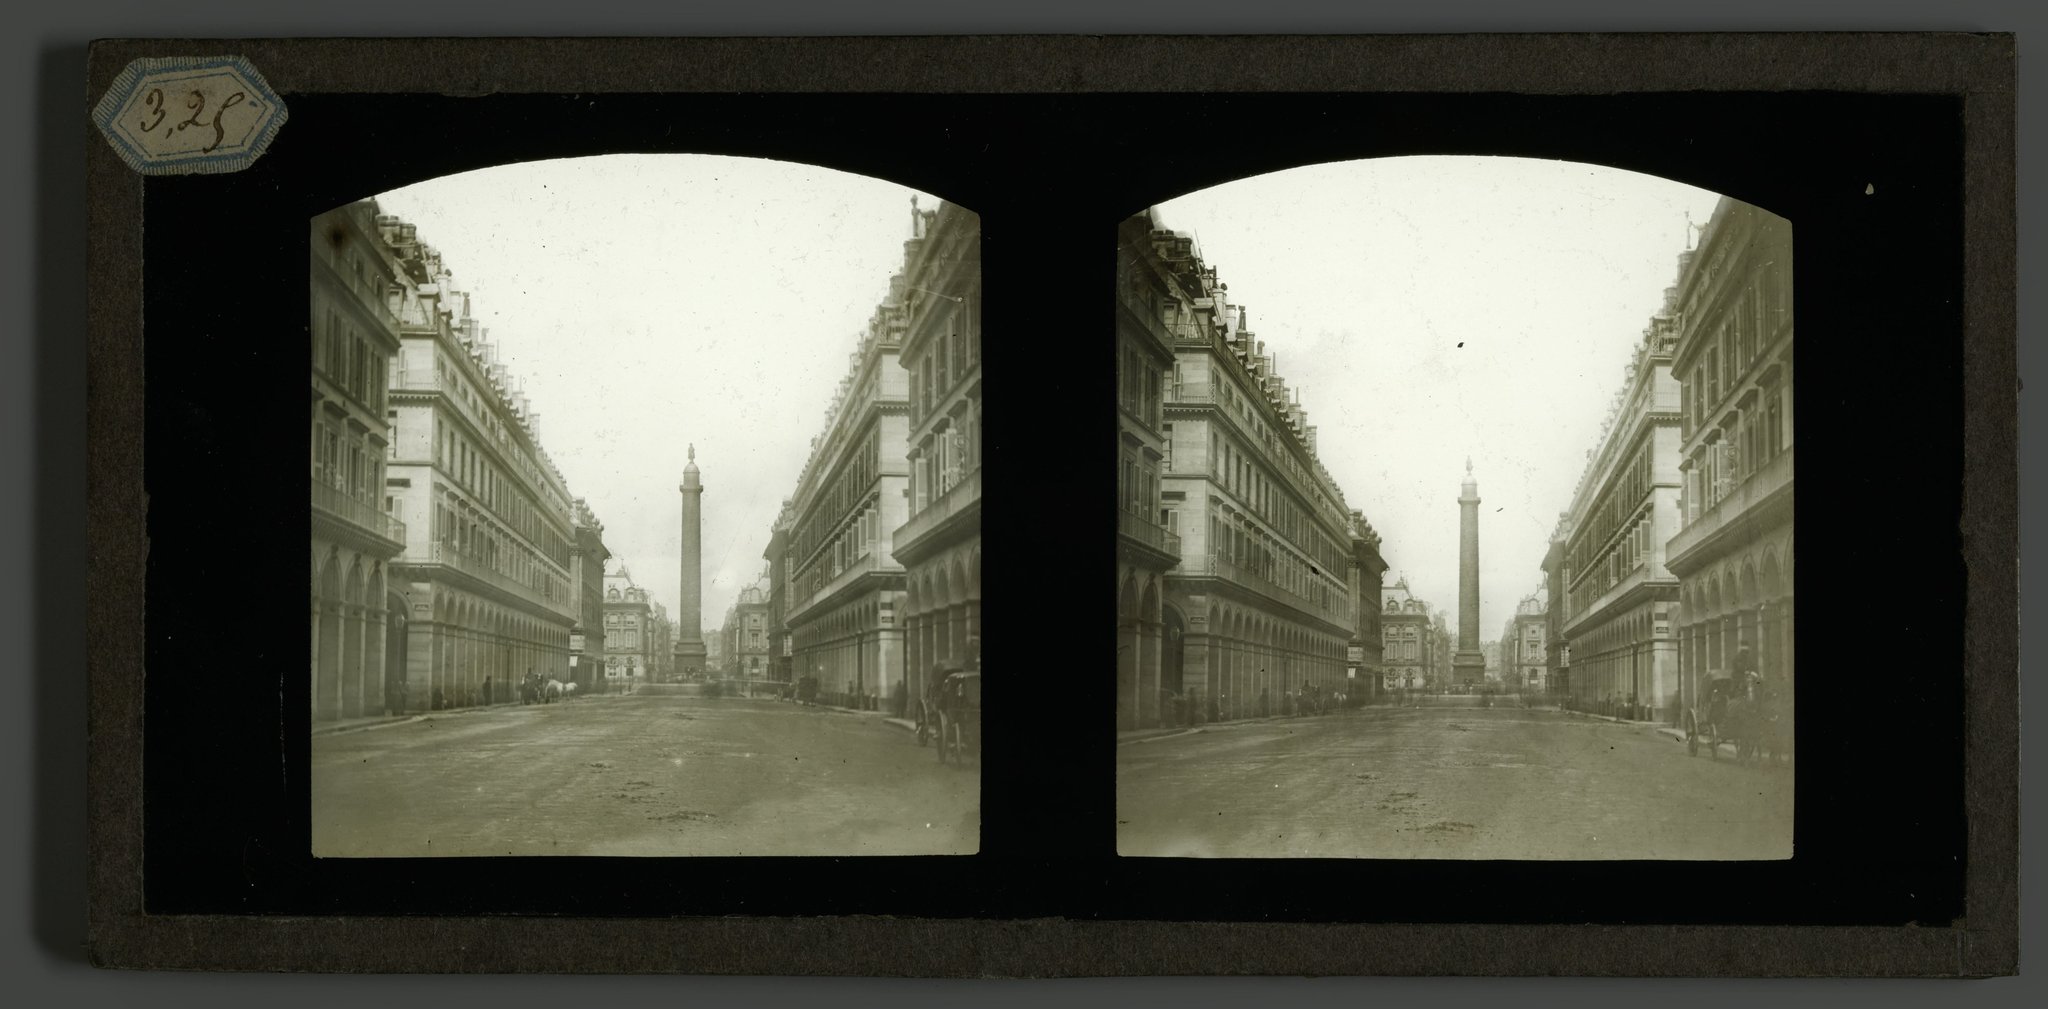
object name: photograph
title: Gezicht op Place Vendôme, Parijs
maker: Anonymous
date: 1855-1865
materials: glass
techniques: photography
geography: paris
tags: square, place, circus, etc.